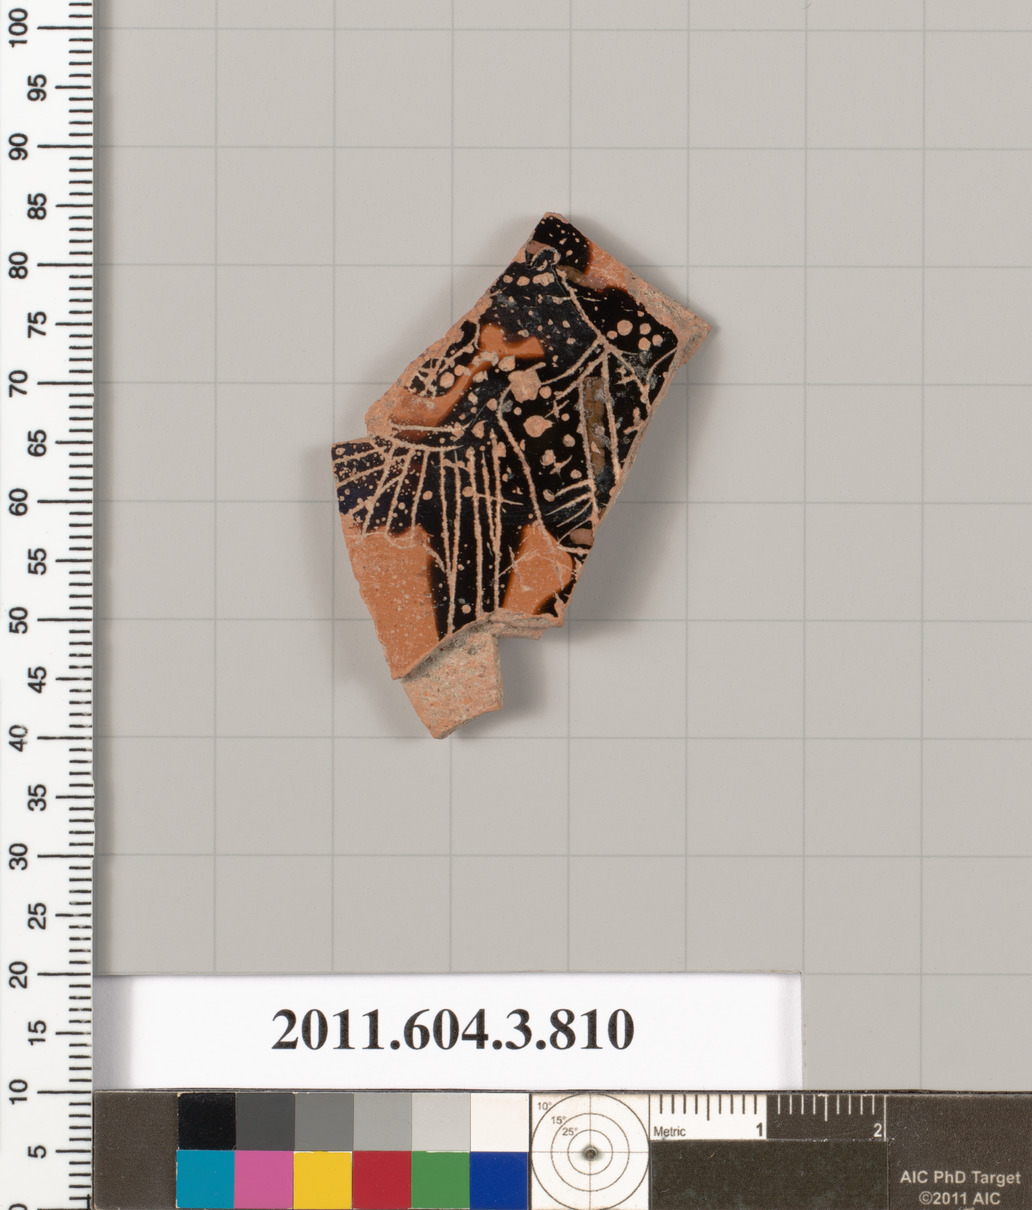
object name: lekythos fragment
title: Terracotta fragment of a lekythos (oil flask)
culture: greek, attic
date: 534-468 BCE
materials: terracotta